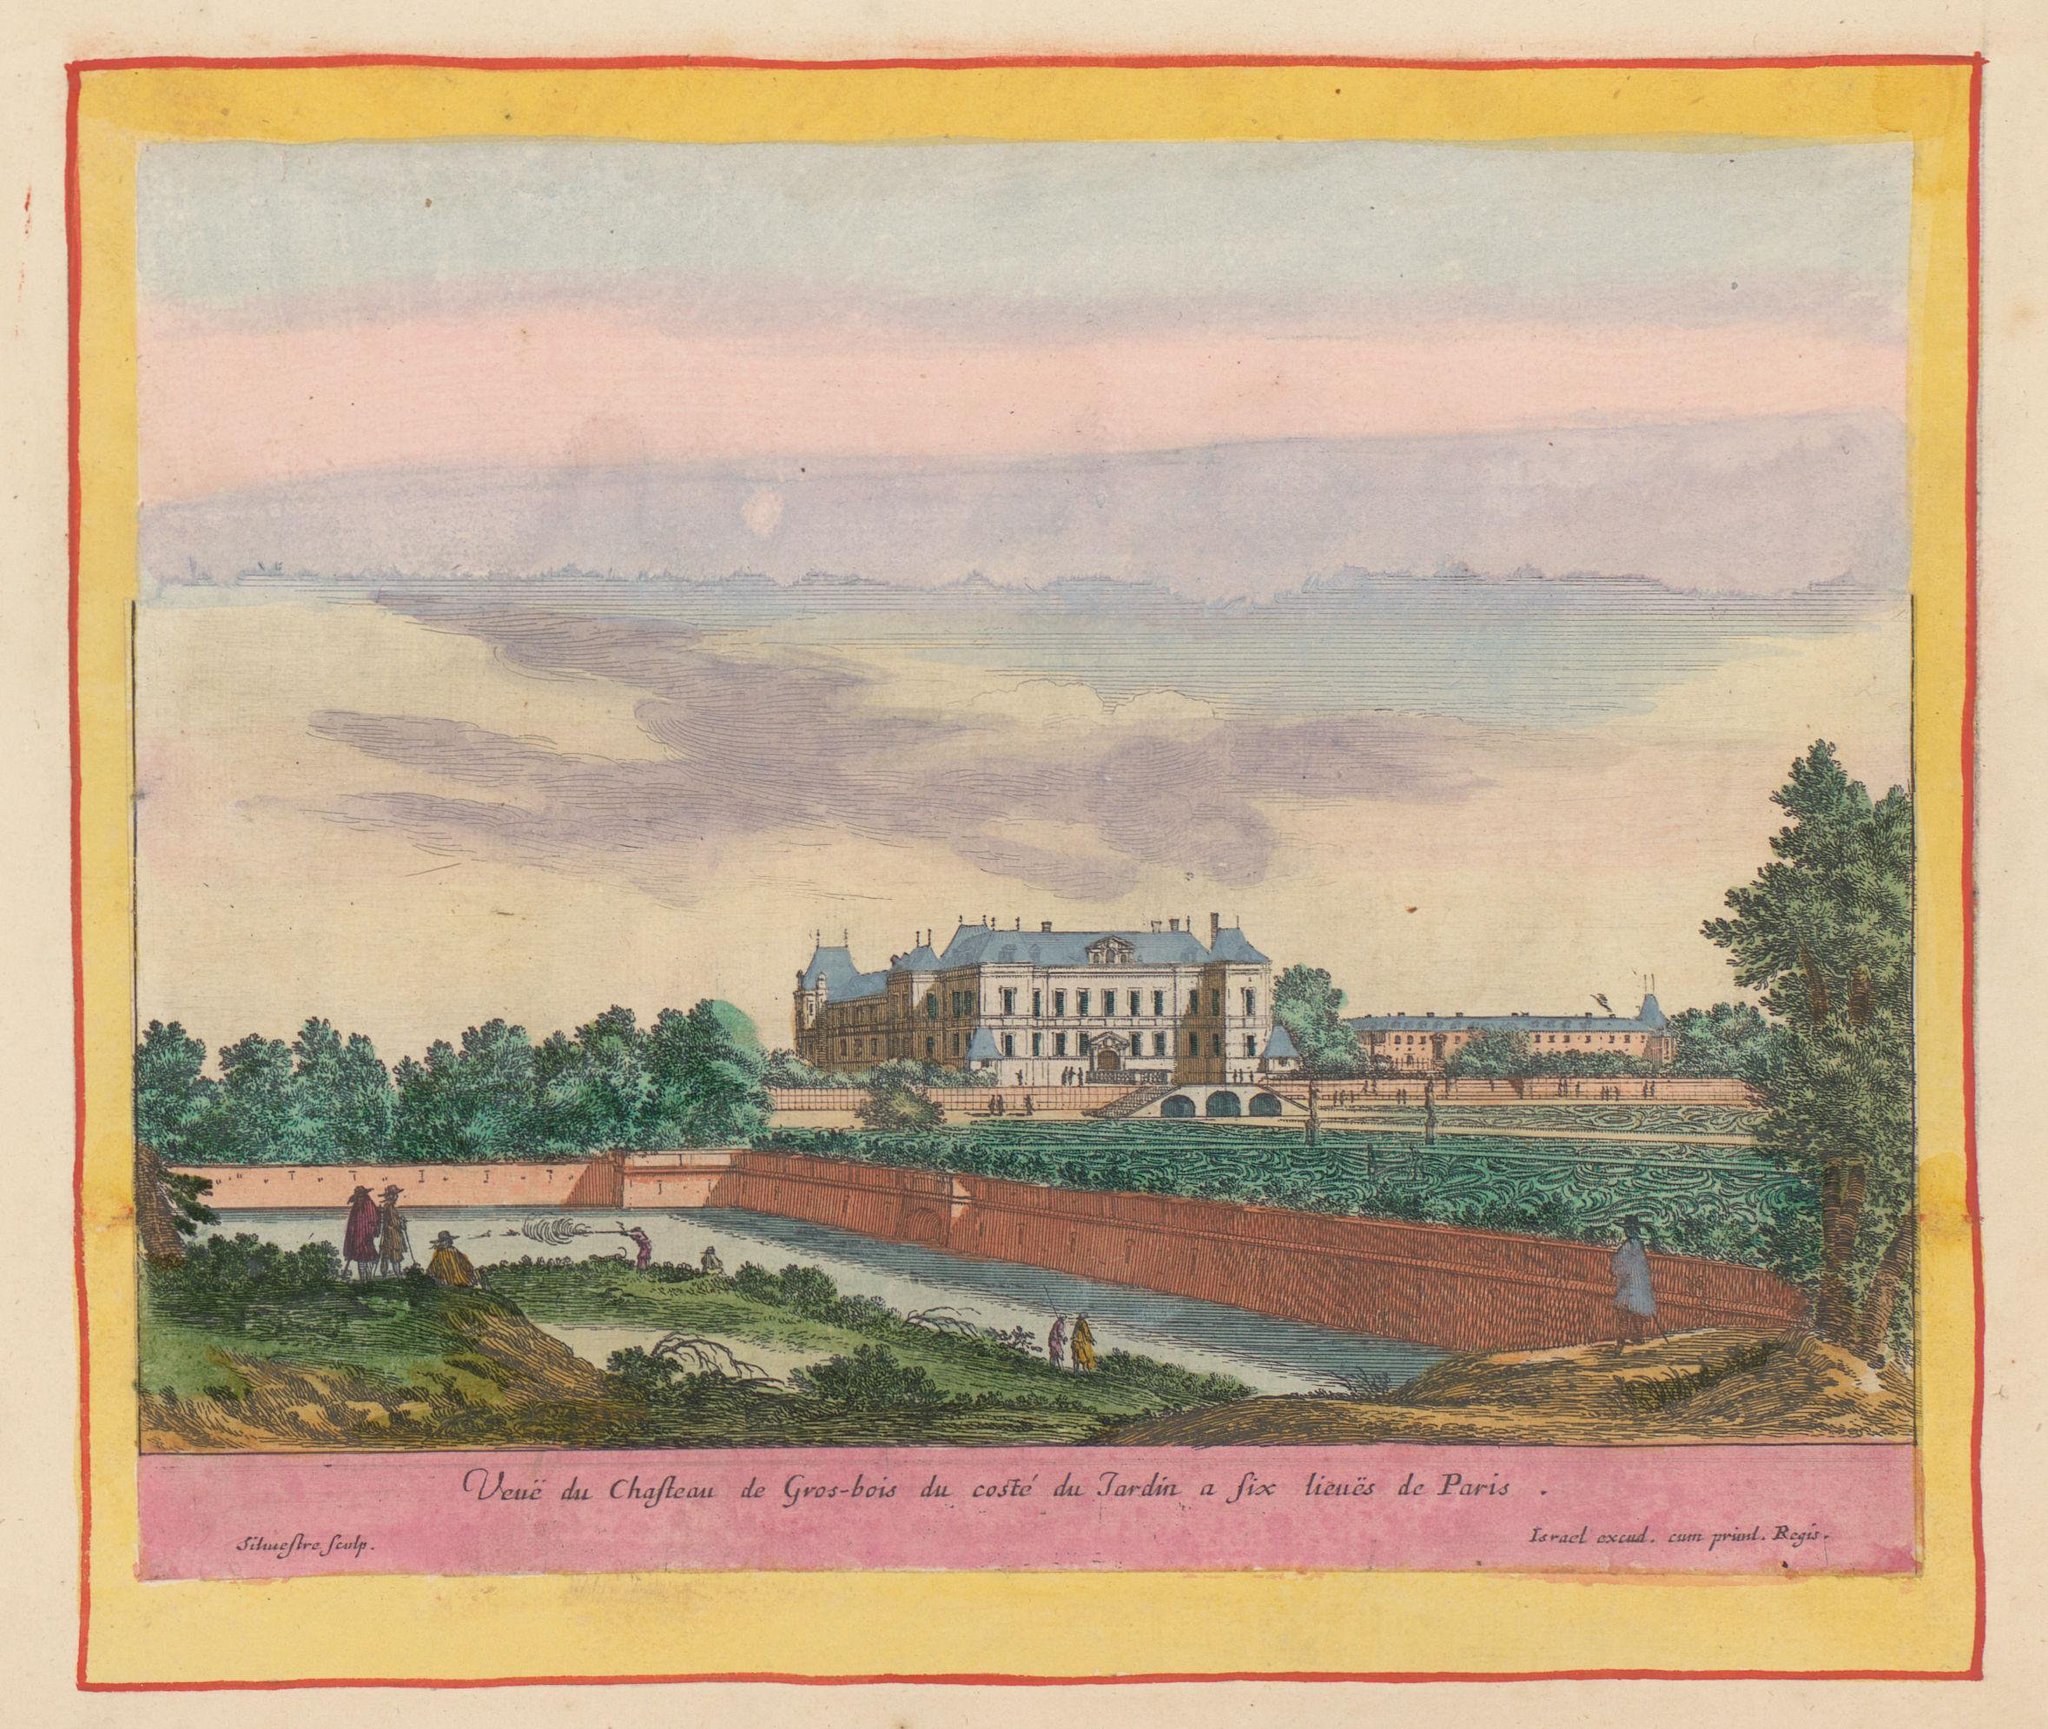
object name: album leaf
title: Gezicht op Château de Grosbois vanaf de tuinen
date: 1631-1691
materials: paper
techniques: etching, hand coloring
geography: paris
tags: castle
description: Gezicht op Château de Grosbois vanaf de tuinen. Prent maakt deel uit van een album.